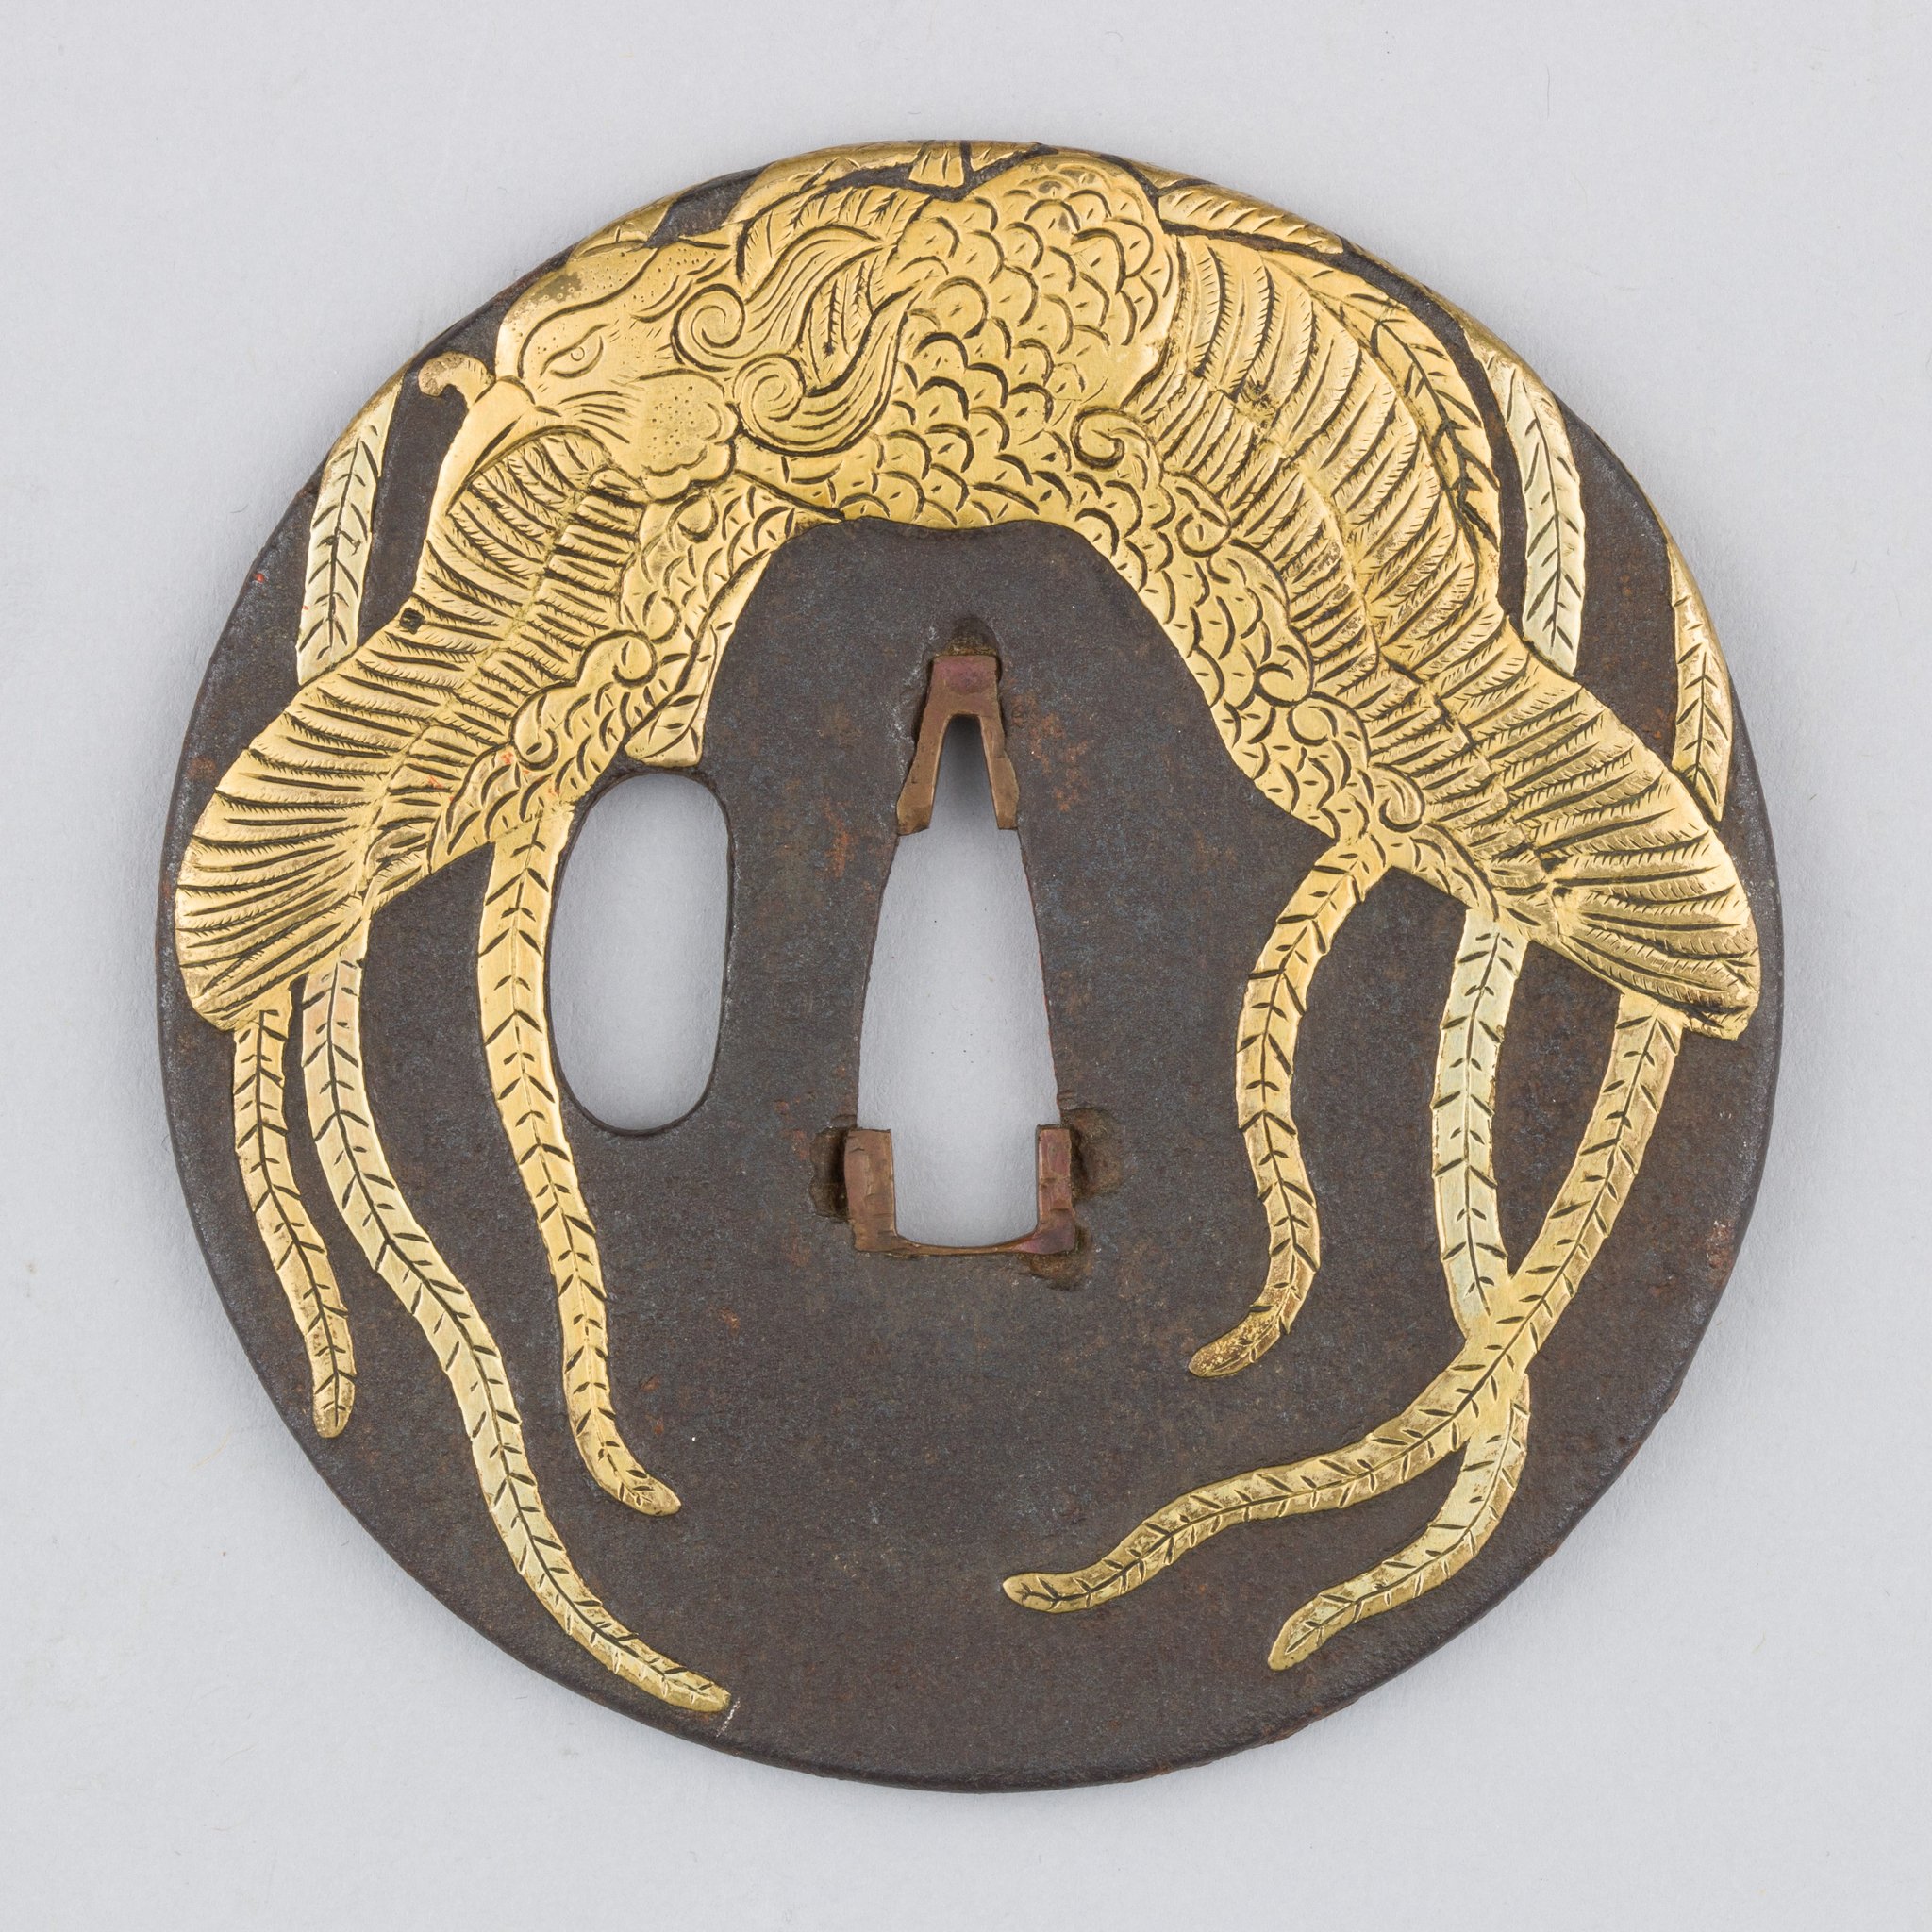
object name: sword guard tsuba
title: Sword Guard (Tsuba)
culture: japanese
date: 1601-1800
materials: copper, gold, iron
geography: japan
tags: birds